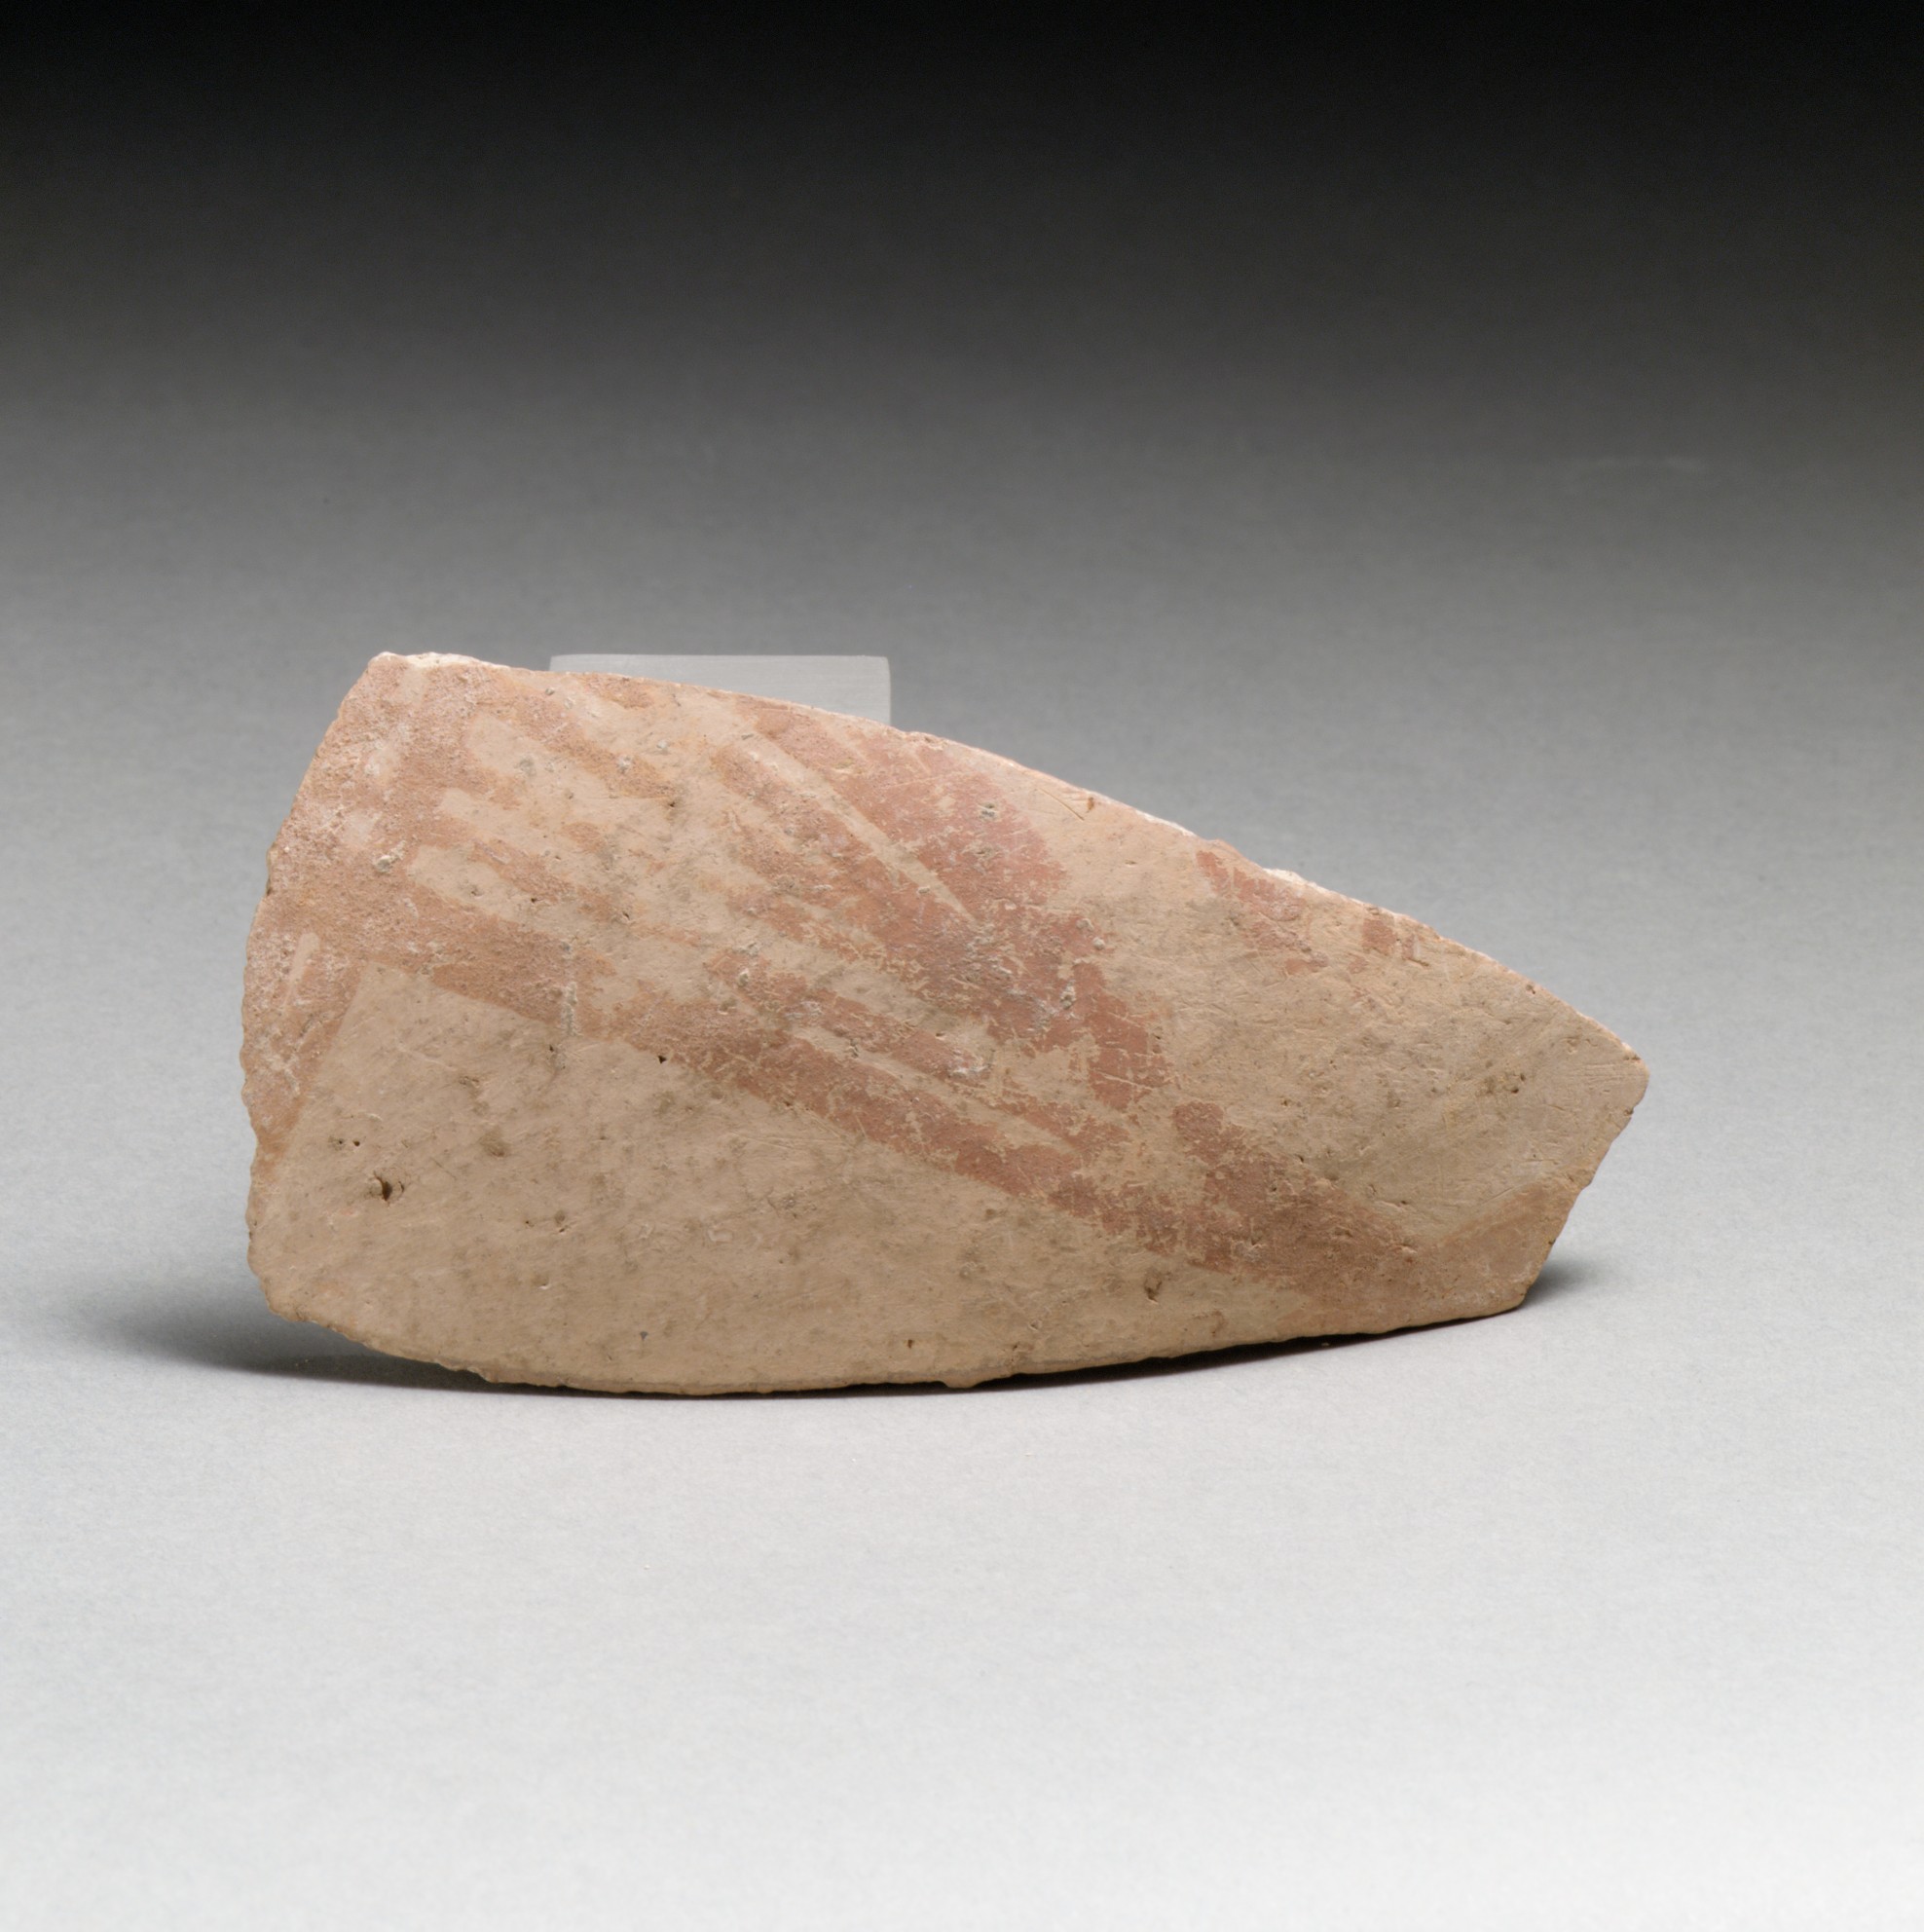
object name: vase fragment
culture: minoan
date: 2600-2000 BCE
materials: terracotta